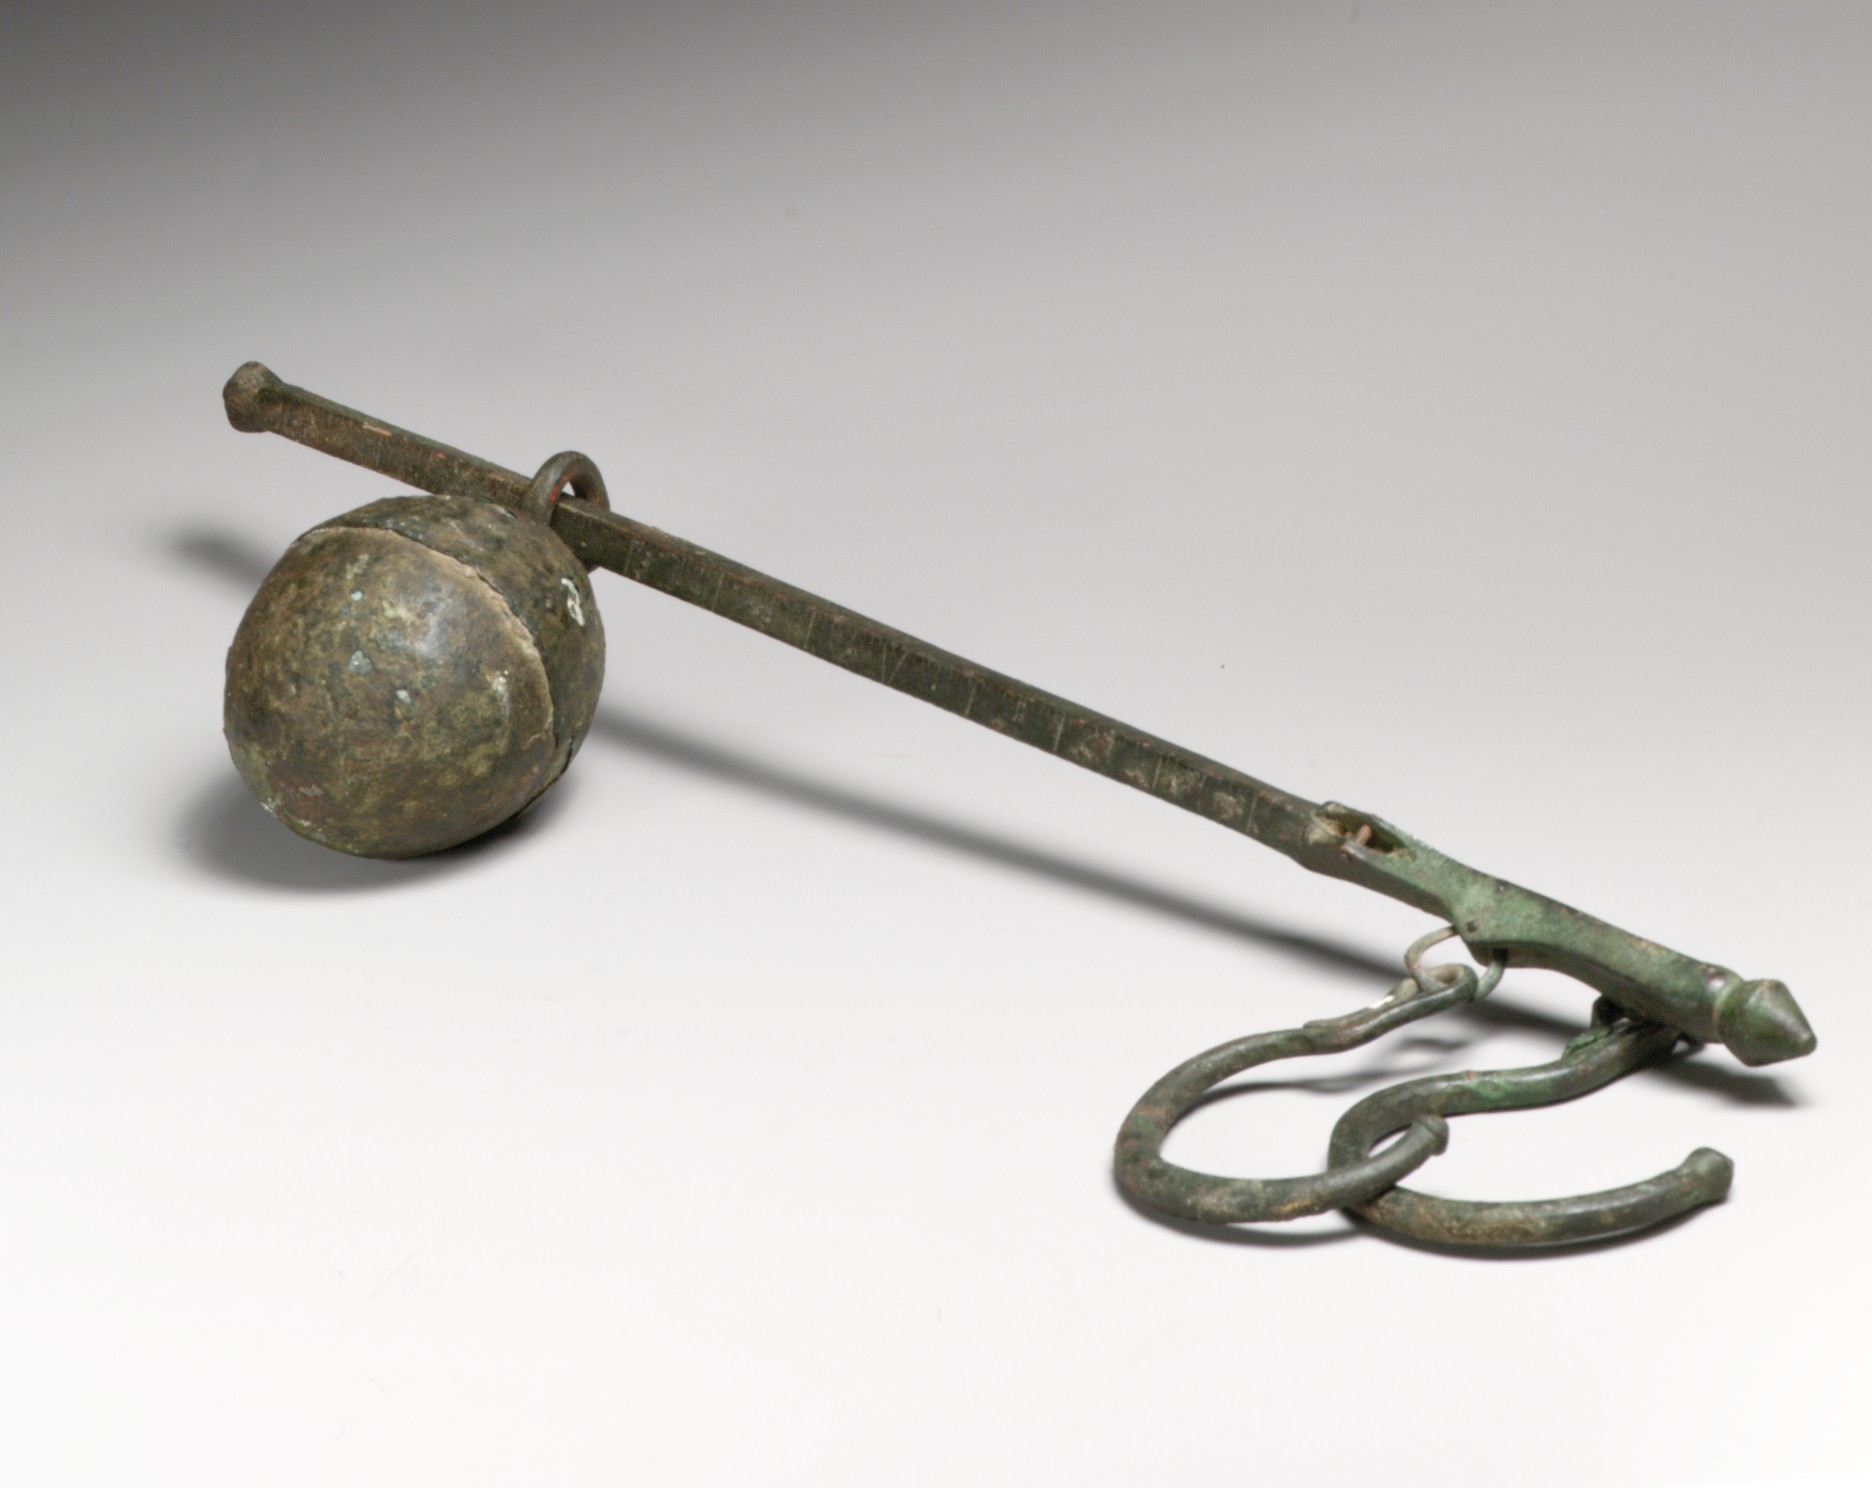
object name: steelyard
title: Bronze steelyard and weights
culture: roman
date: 301-600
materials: bronze